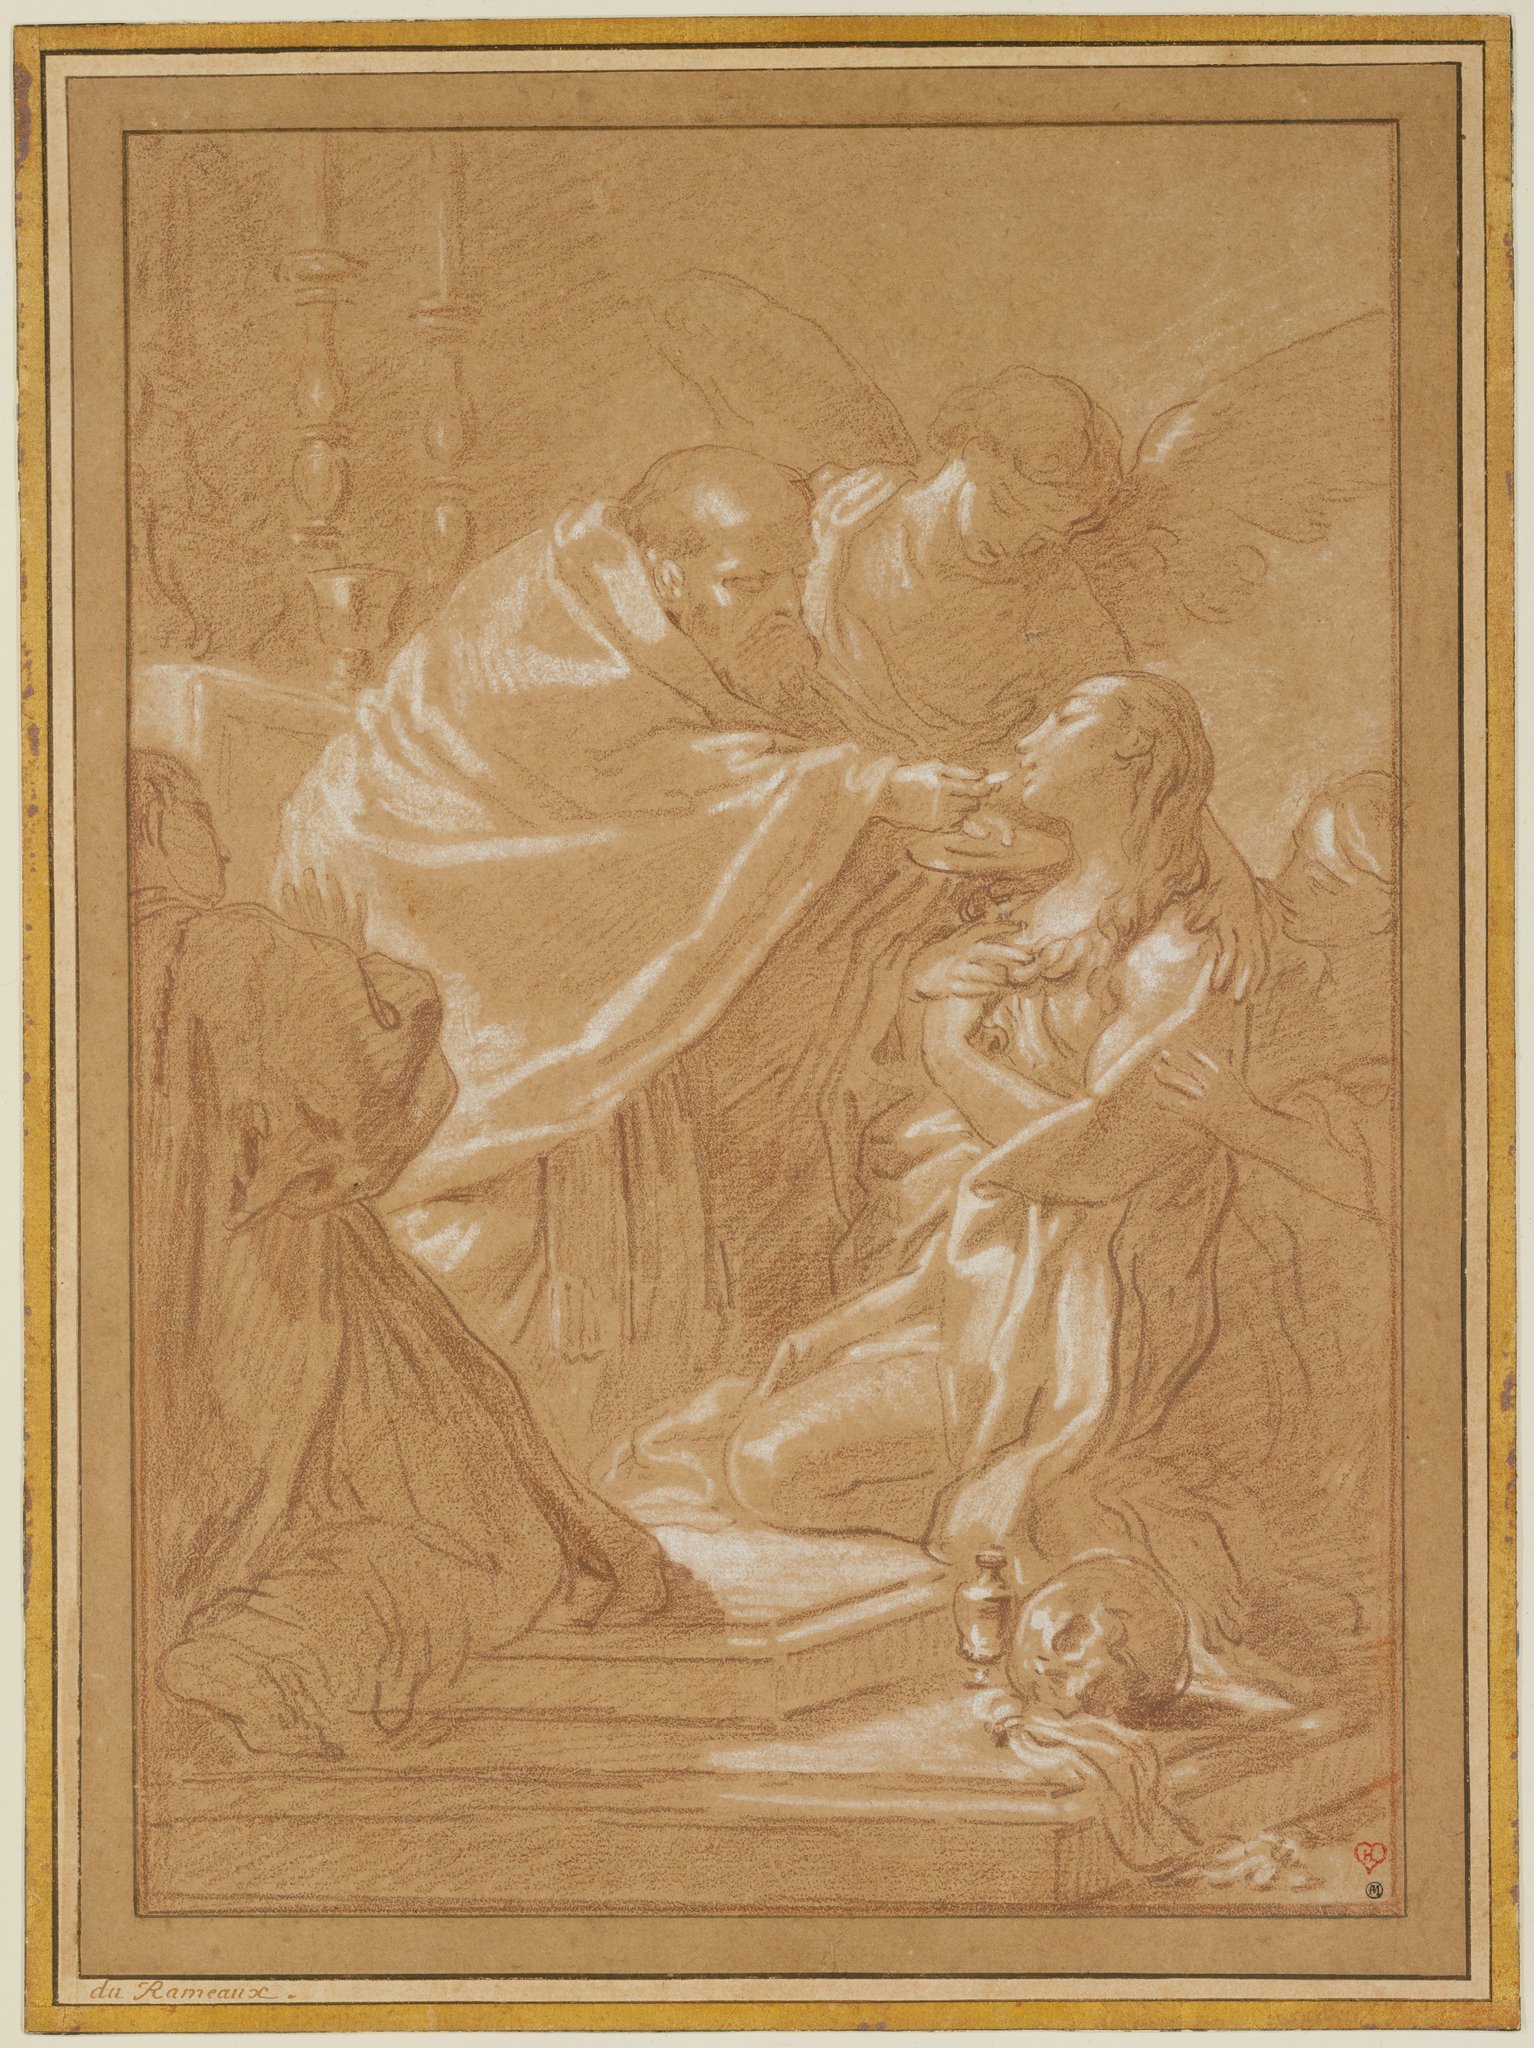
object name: drawing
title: The Last Communion of St. Mary Magdalen, after Benedetto Luti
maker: louis jean jacques durameau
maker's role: artist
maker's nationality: french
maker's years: 1733-1796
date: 1761-1764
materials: chalk, ink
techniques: heightening, pen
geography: france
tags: men,angels,mary magdalene